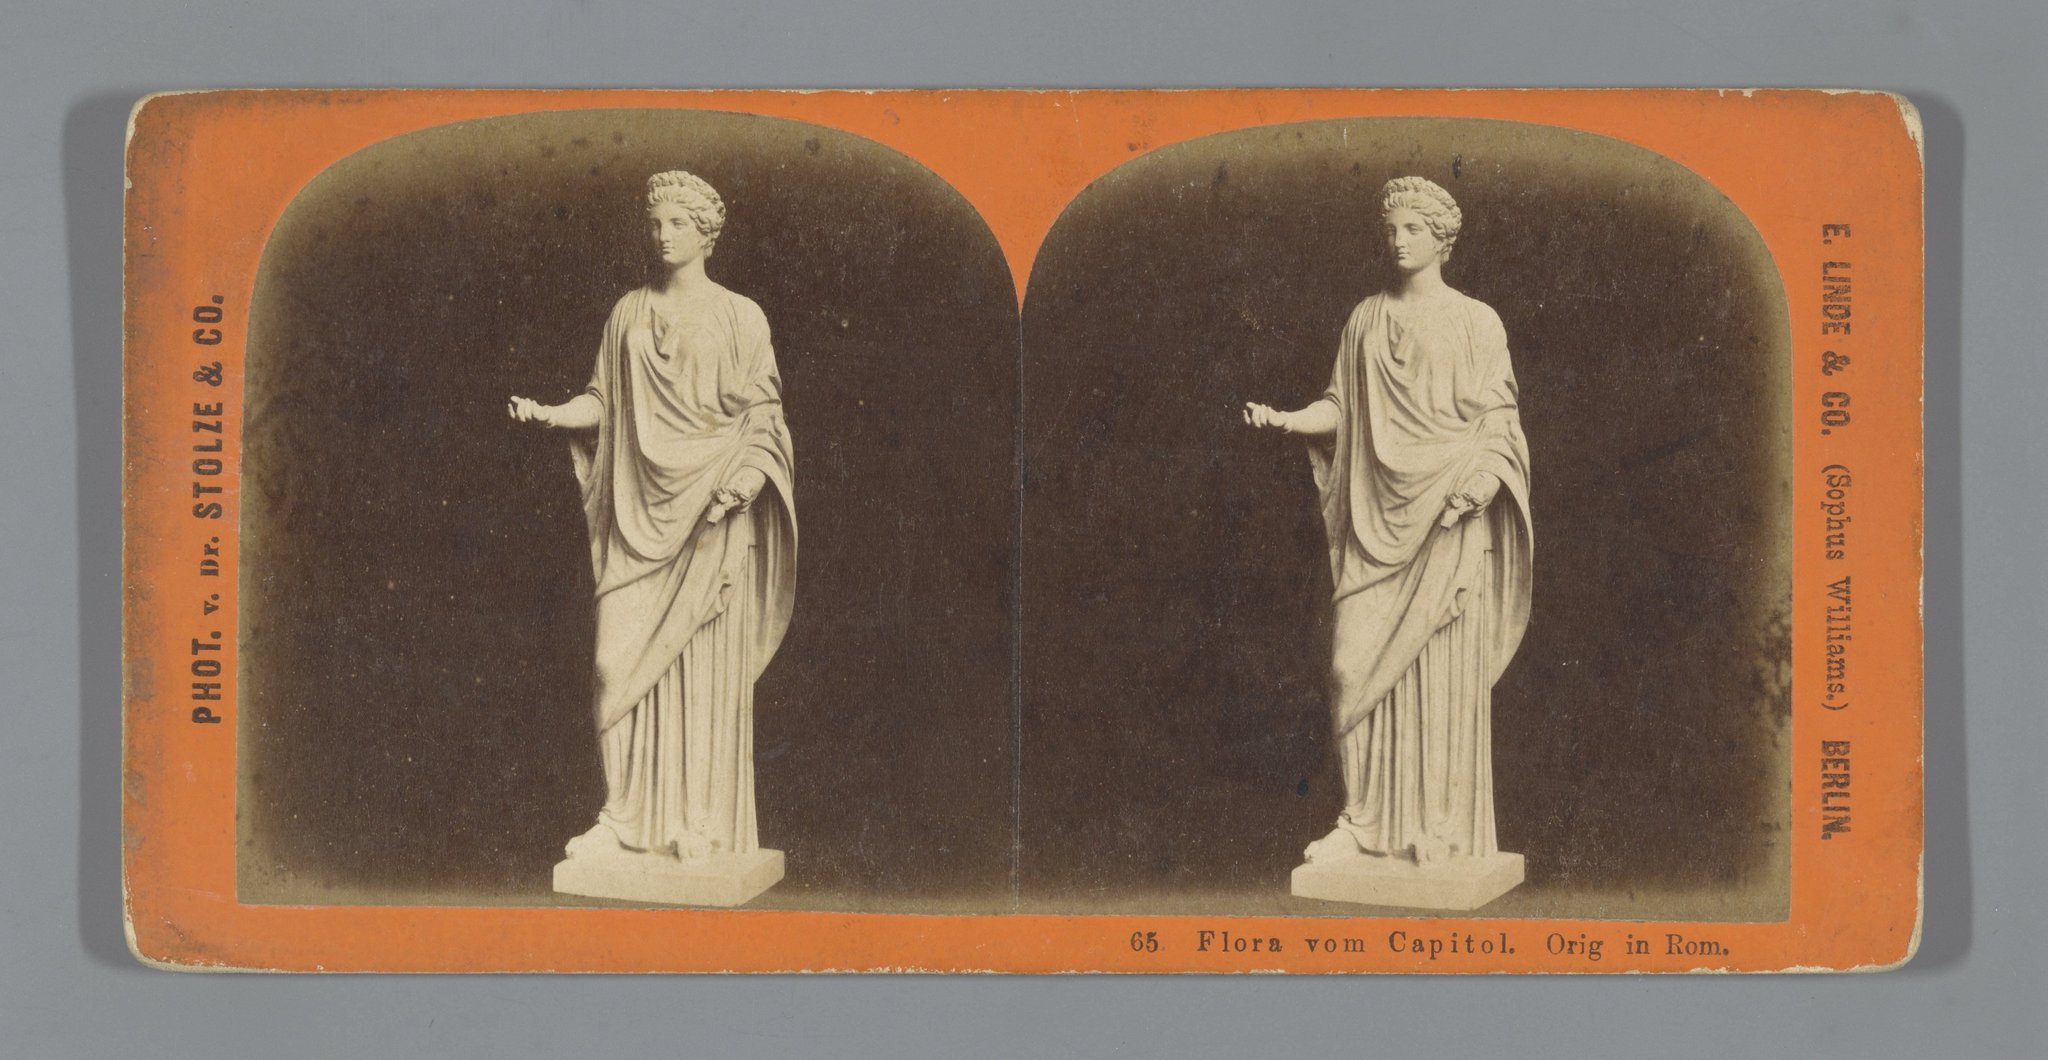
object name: stereograph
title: Flora vom Capitol. Original in Rom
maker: karl heinrich franz stolze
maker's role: fotograaf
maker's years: 1836-1910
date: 1855-1890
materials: cardboard, photographic support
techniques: albumen print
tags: sculpture, (story of) flora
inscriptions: : ‘Berlin’, number: ‘65’